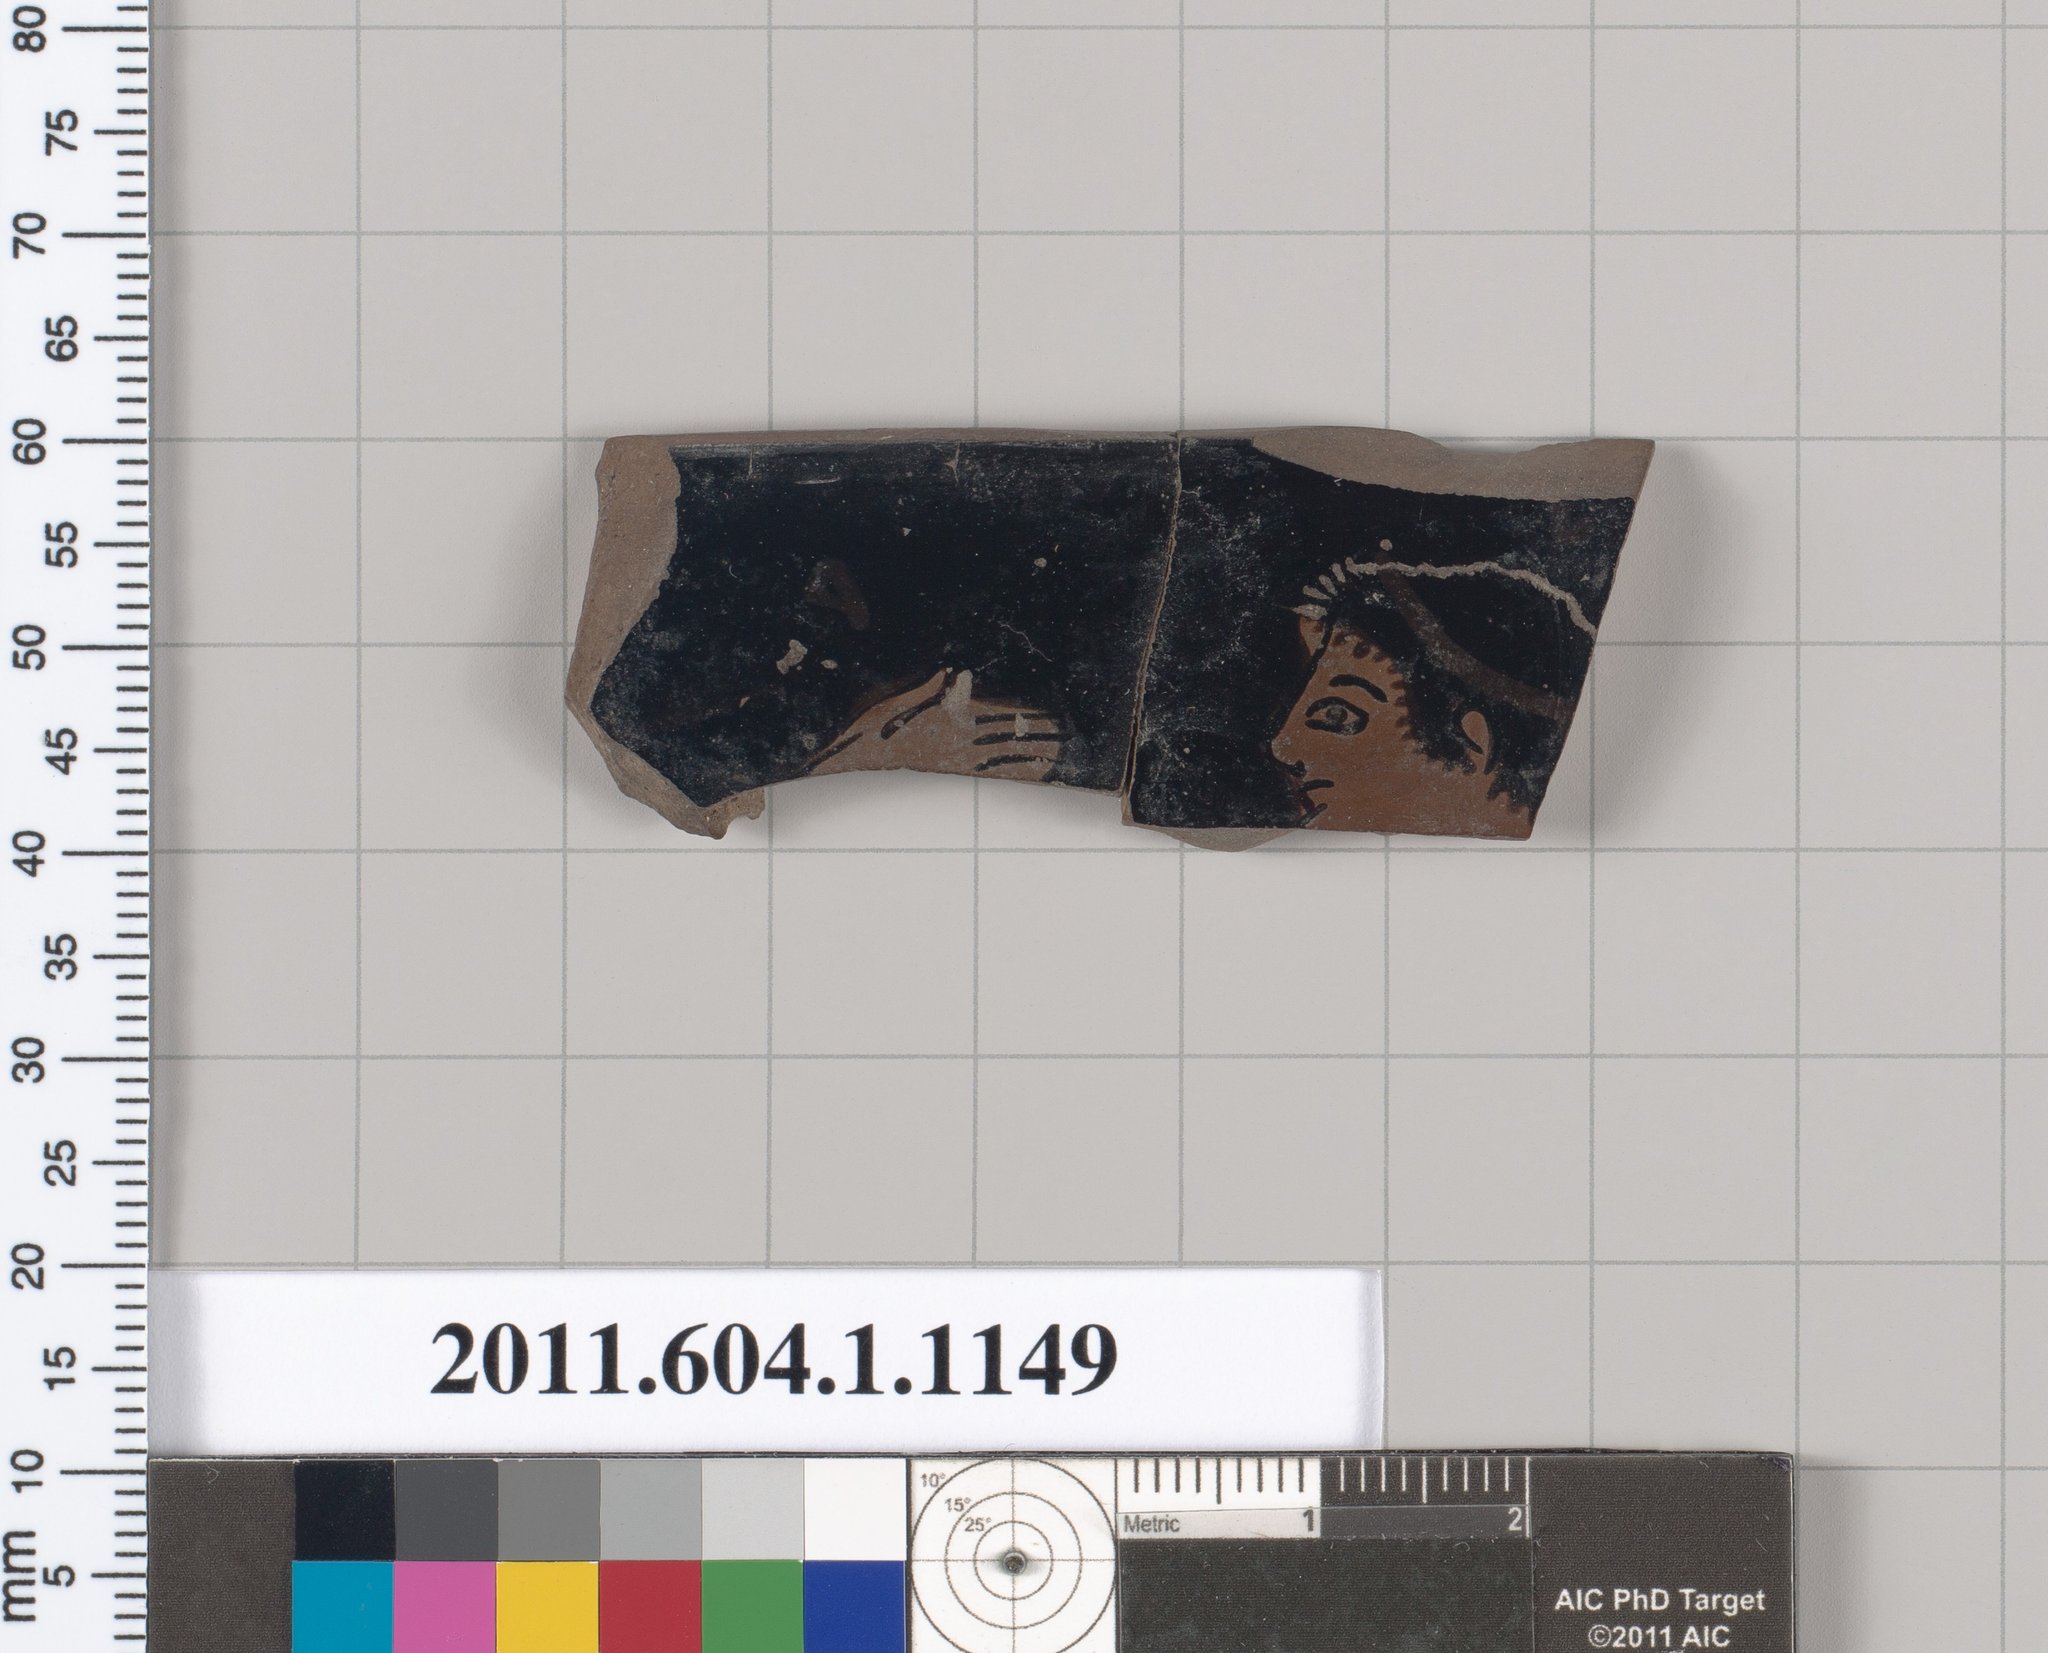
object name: kylix fragment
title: Terracotta rim fragment of a kylix (drinking cup)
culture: greek, attic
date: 520-500 BCE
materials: terracotta